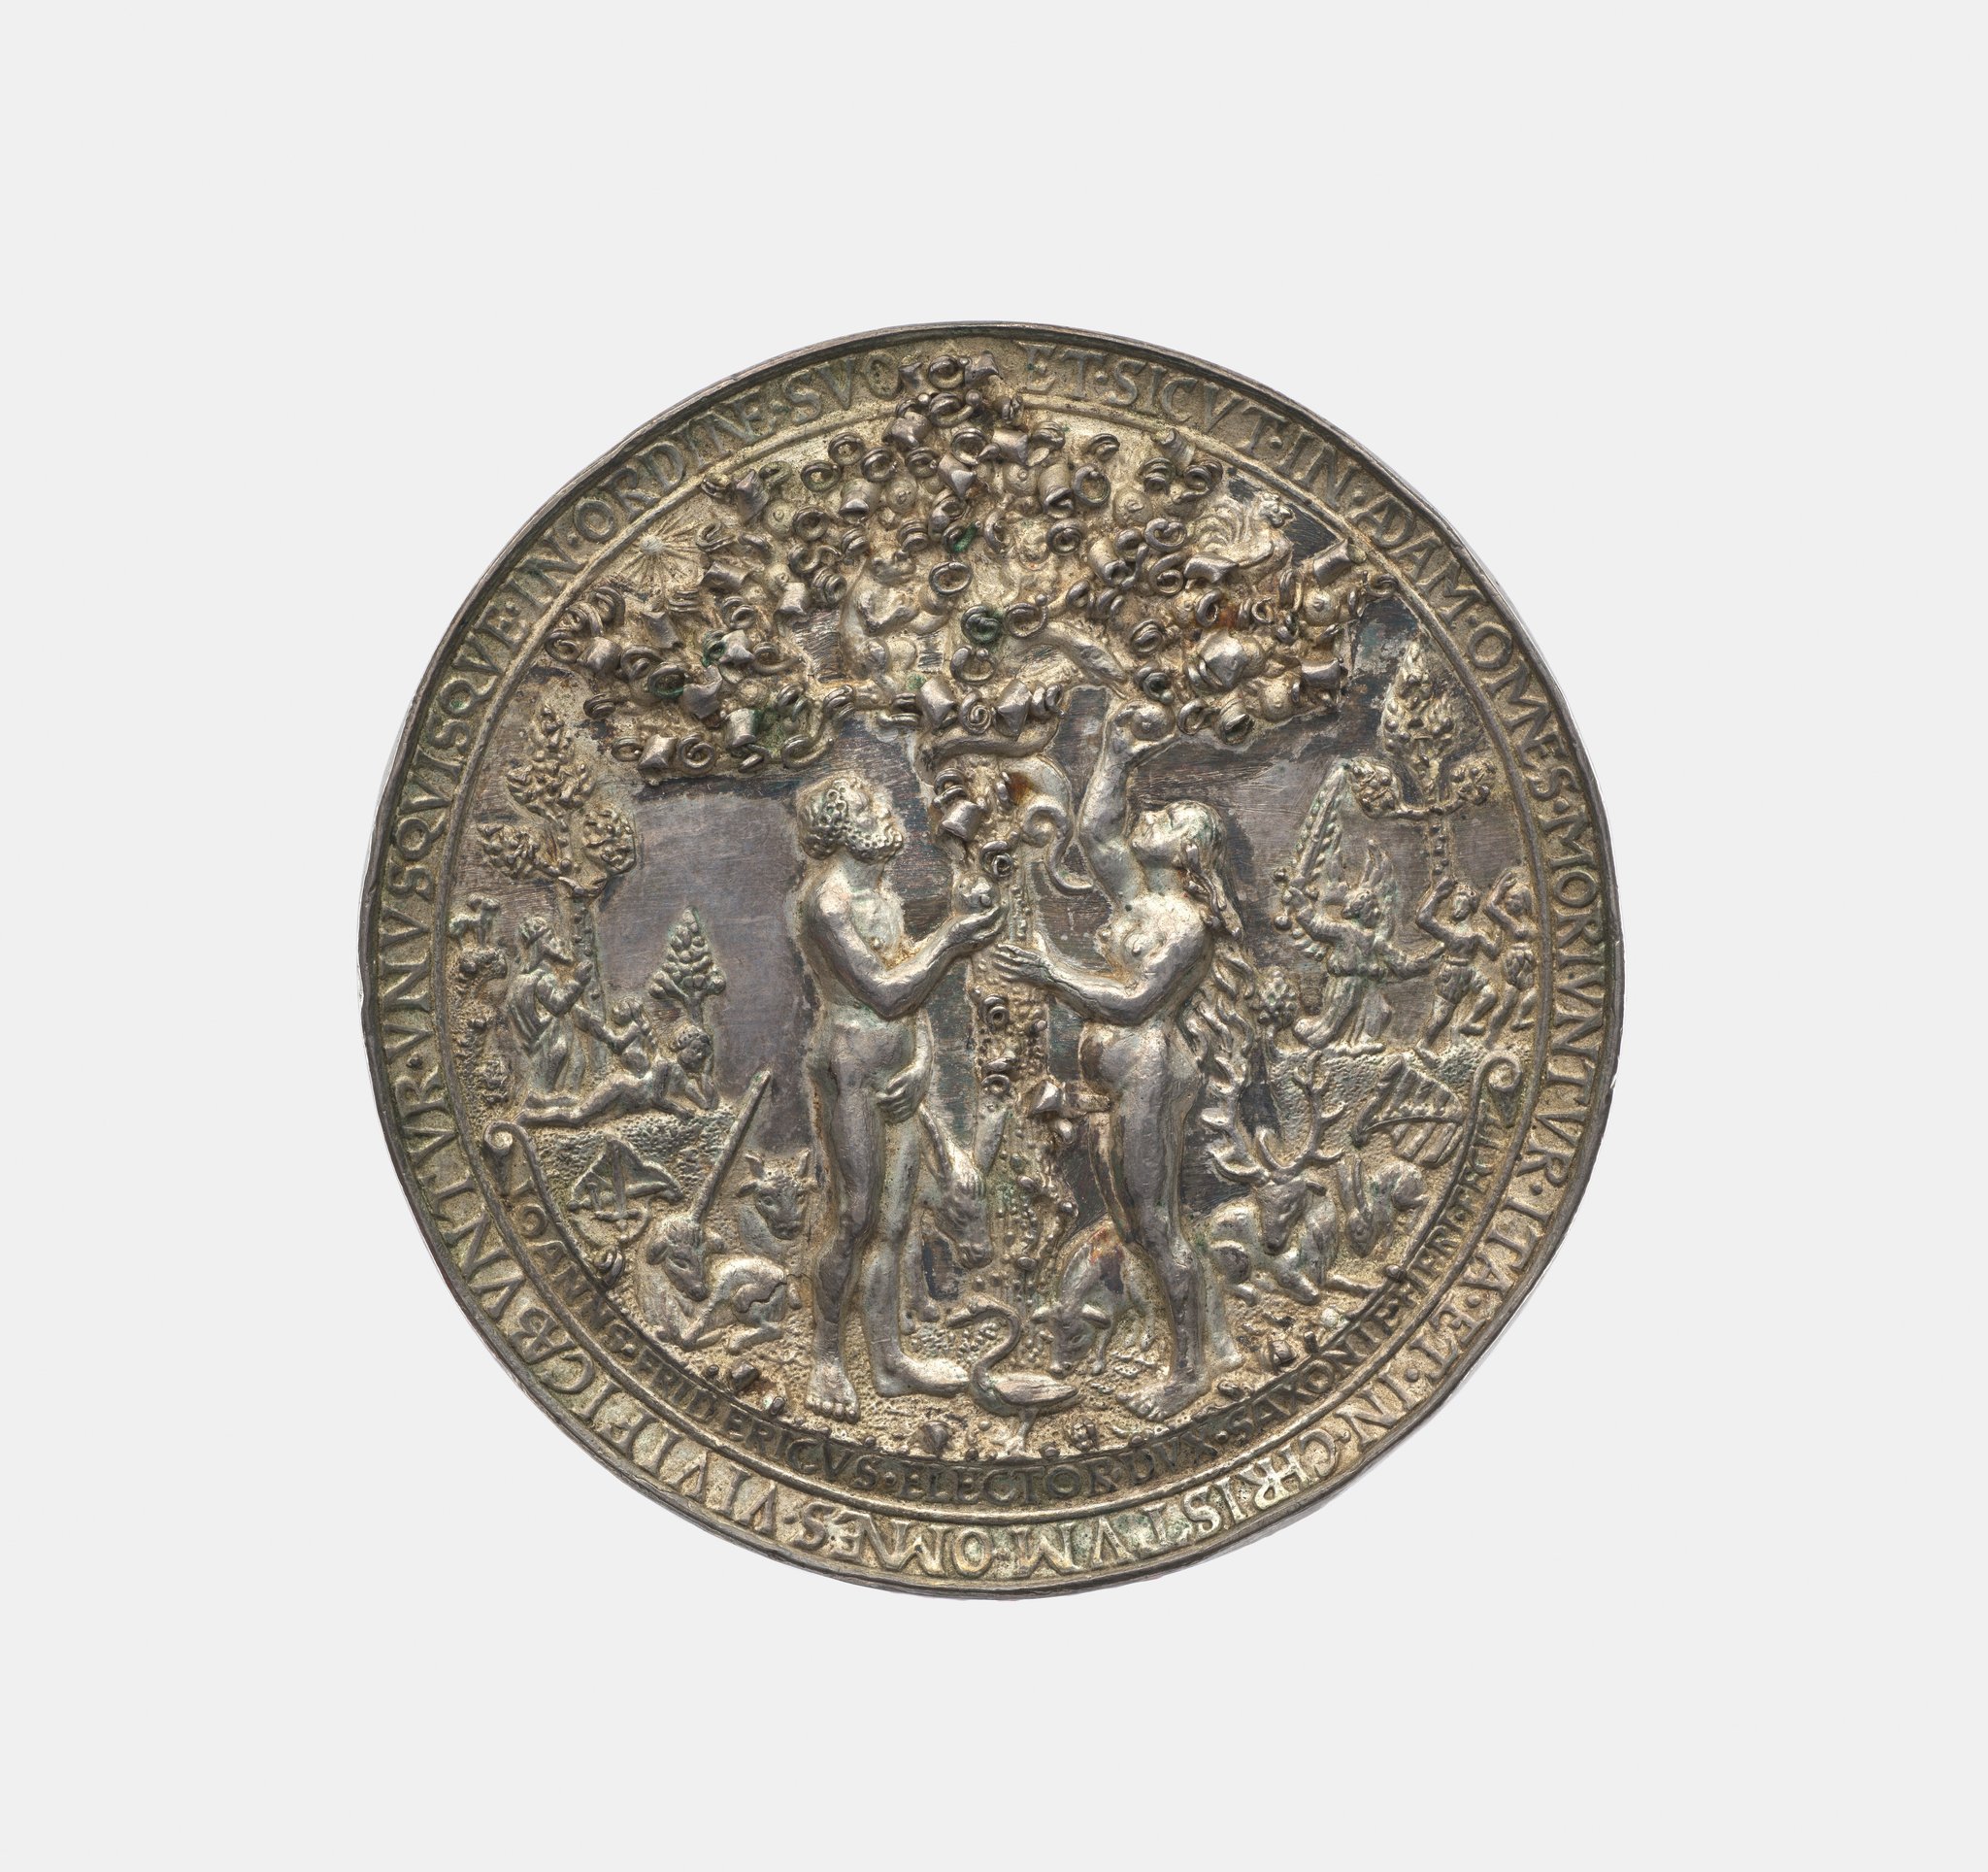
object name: medal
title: Fall of Man | Crucifixion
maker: hans reinhart the elder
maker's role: artist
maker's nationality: german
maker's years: 1500-1581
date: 1536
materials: silver